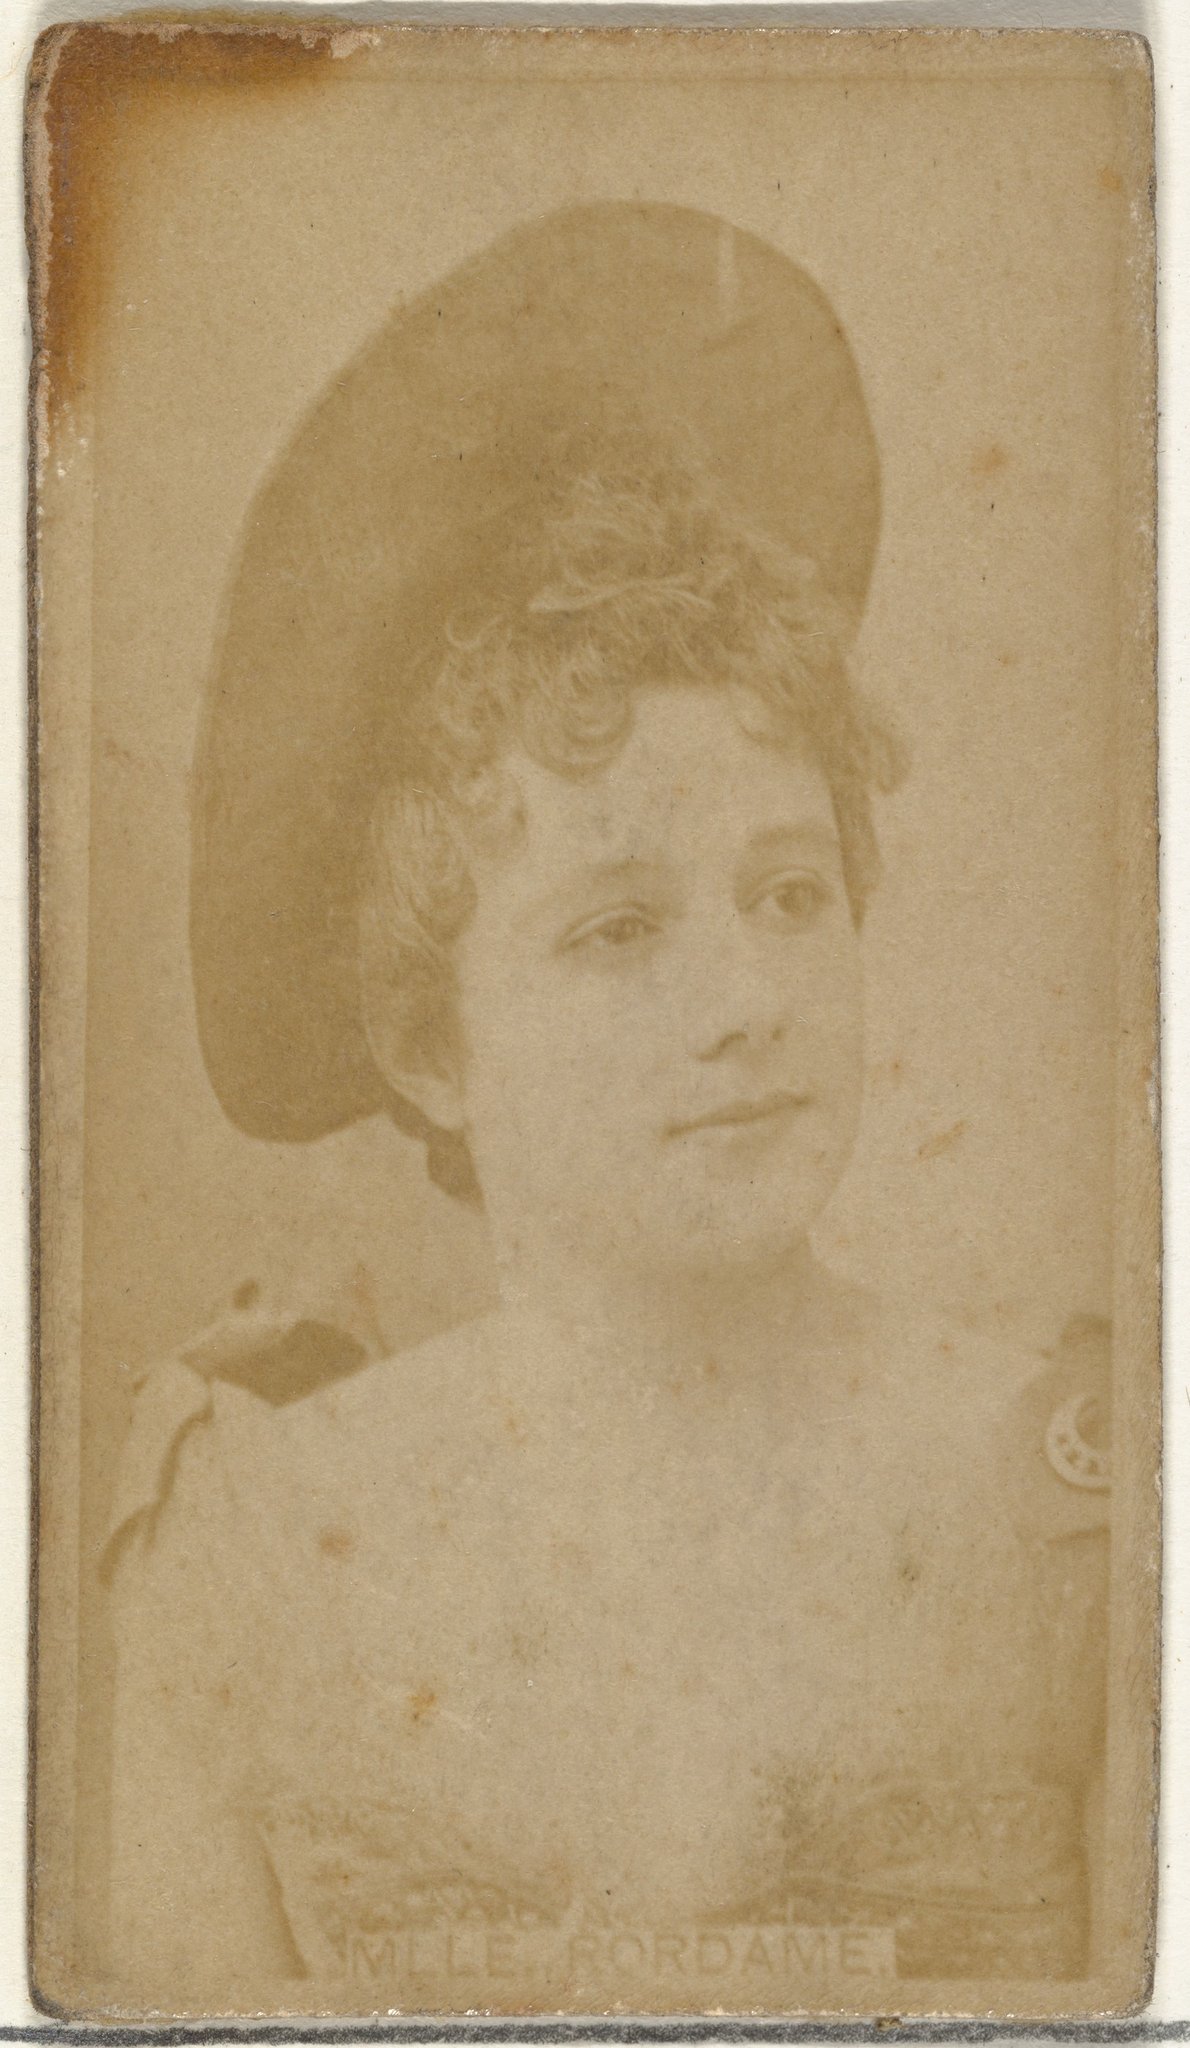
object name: photograph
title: Mlle. Rordame, from the Actors and Actresses series (N145-8) issued by Duke Sons & Co. to promote Duke Cigarettes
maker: w. duke, sons & co.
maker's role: publisher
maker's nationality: american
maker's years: 1870-1920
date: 1891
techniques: albumen silver print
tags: portraits,women,actresses